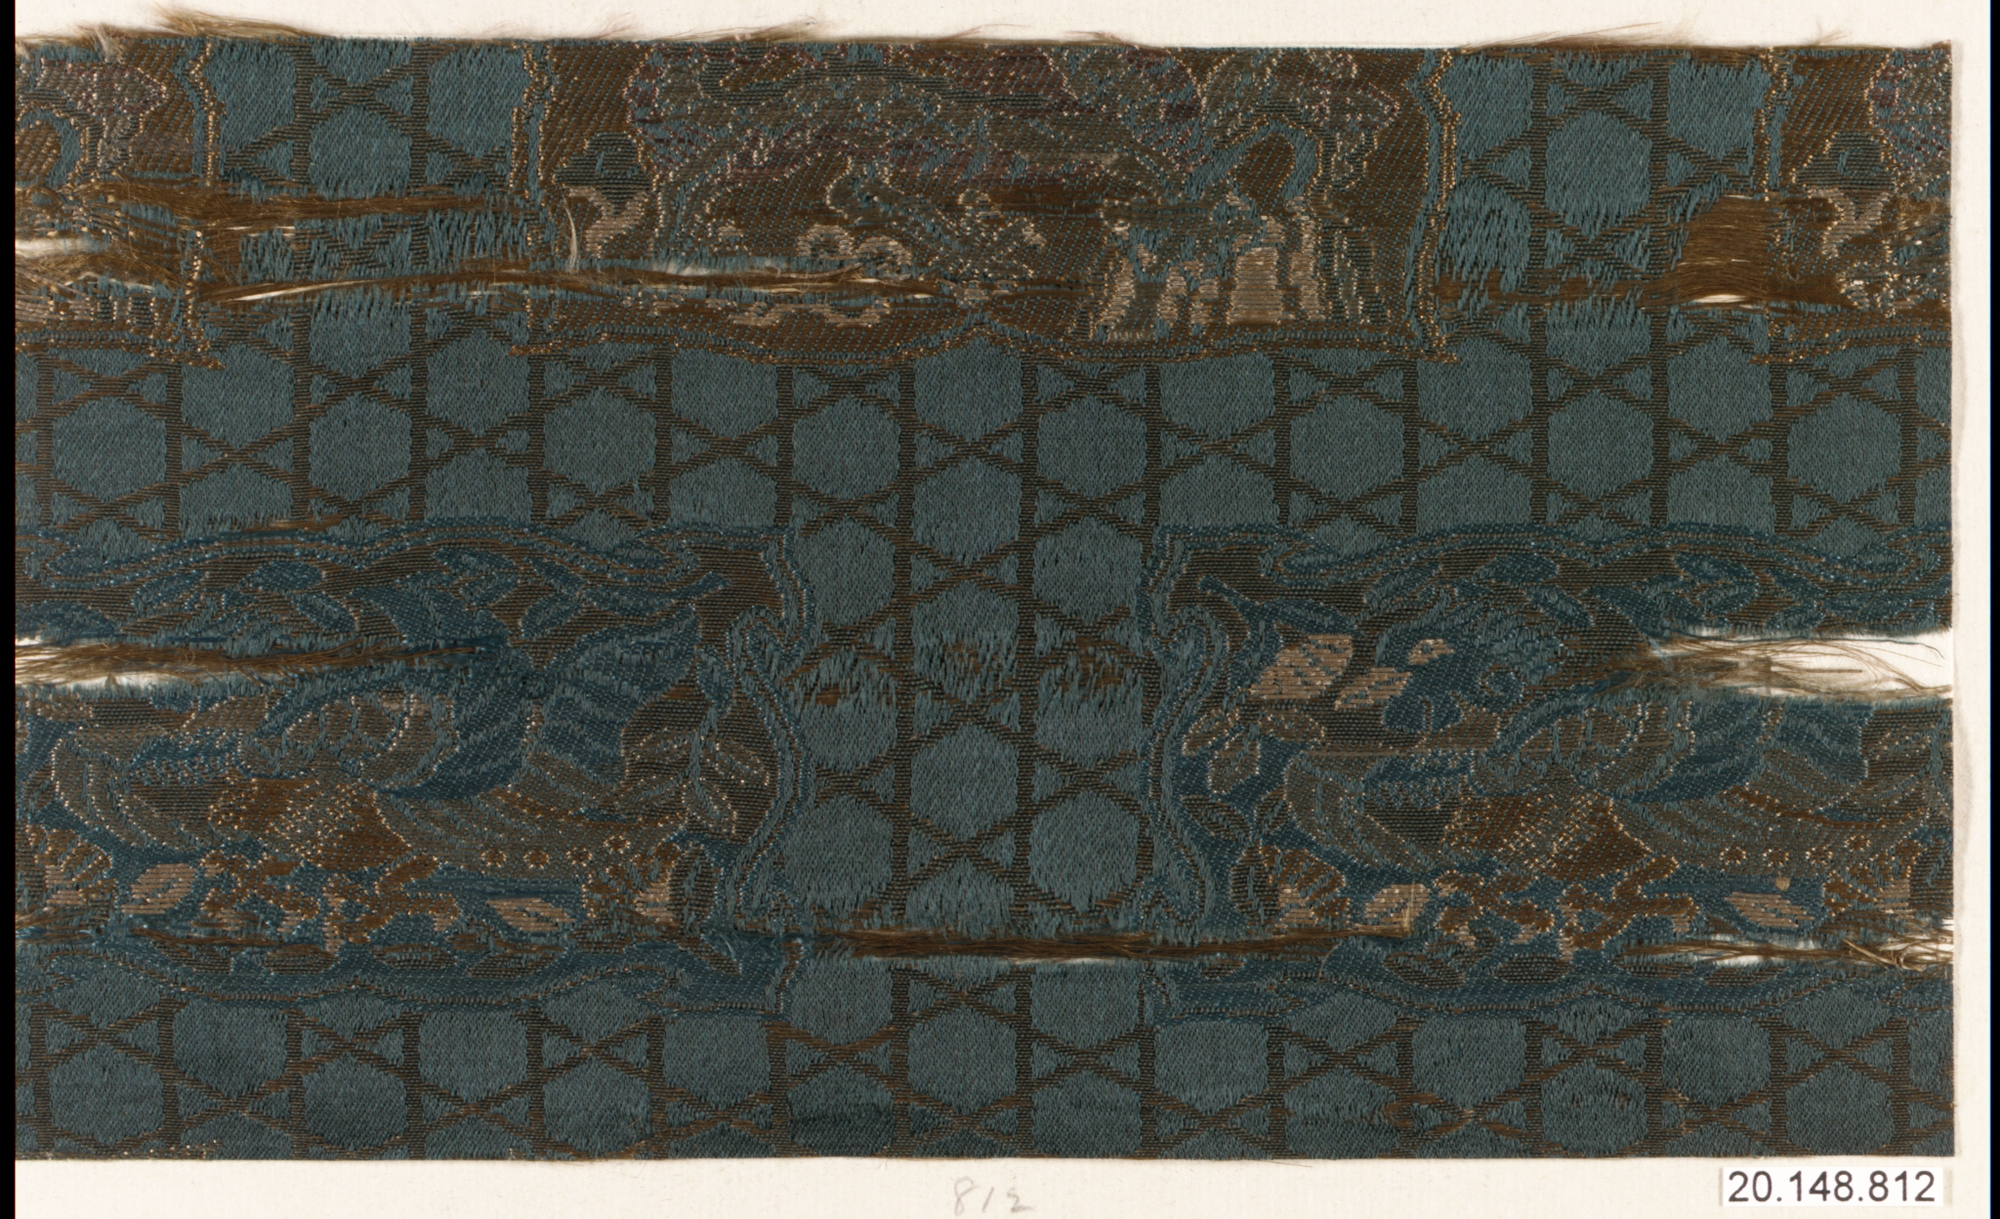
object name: piece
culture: japanese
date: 1701-1800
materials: silk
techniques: compound weave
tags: mythical creatures